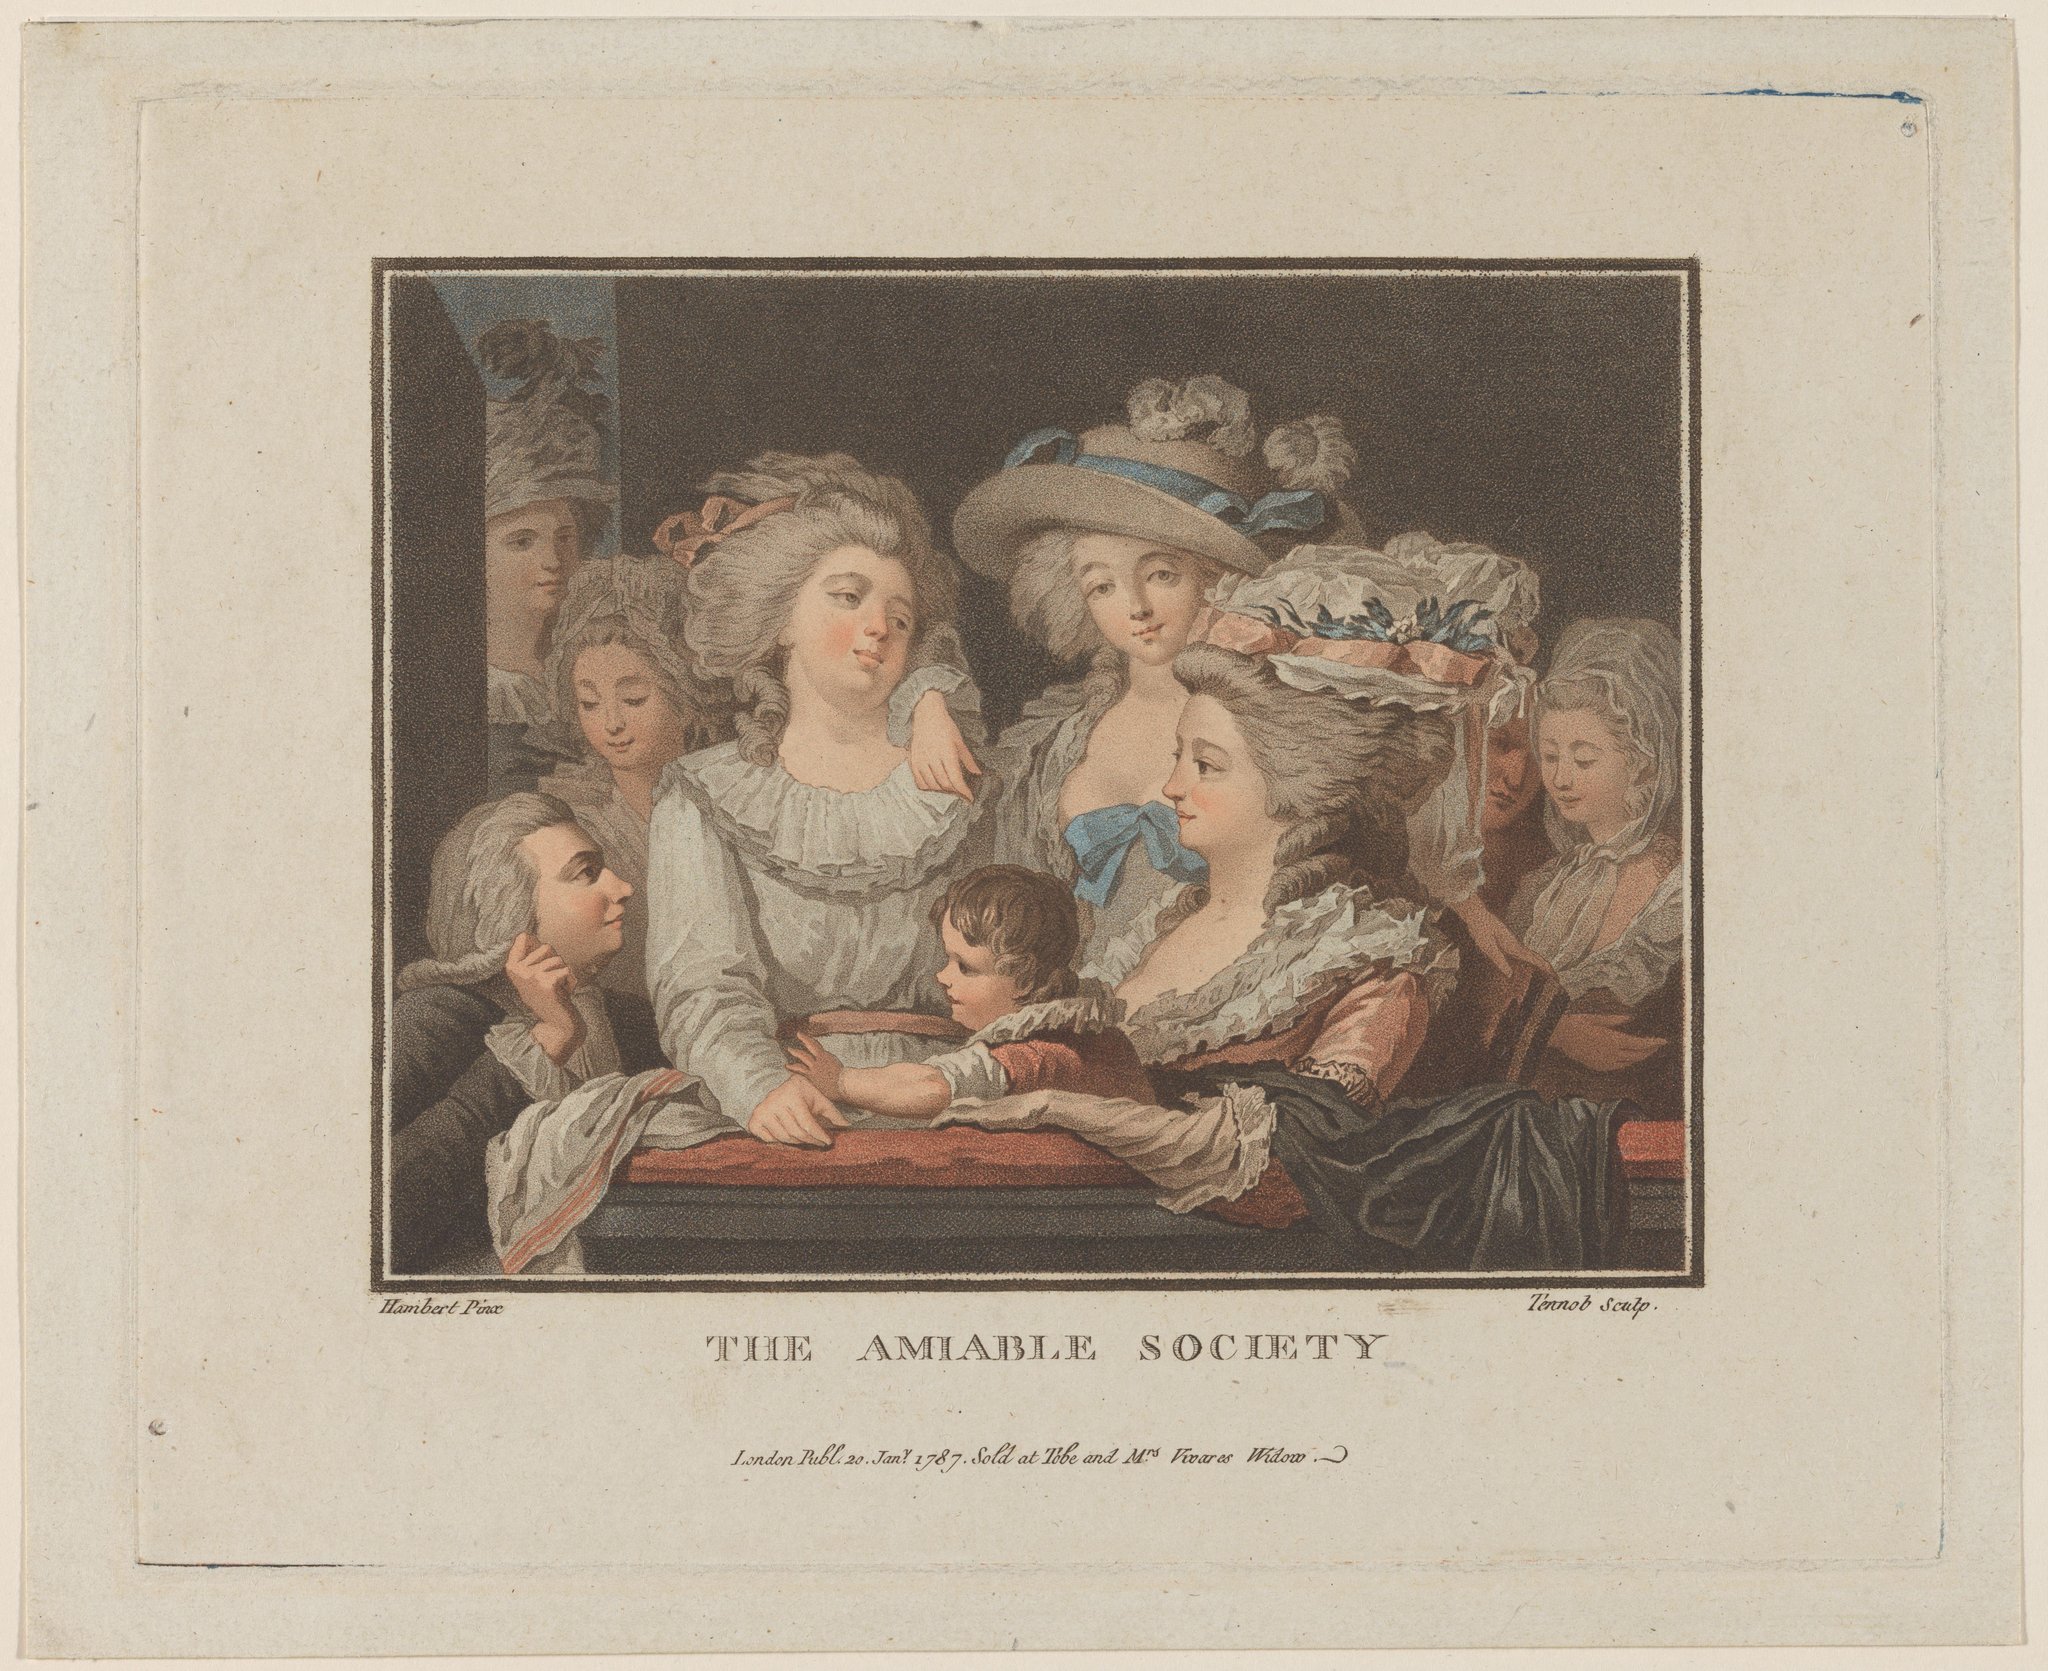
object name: print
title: The amiable society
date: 1787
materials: paper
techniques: engraving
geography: england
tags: boxes, loges ~ theatre, etc., mother and baby or young child, mother-love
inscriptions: collector's mark: Lugt 2228, collector's mark: Lugt 2760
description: Centrale groep van drie vrouwen om een kind, omringd door andere vrouwen en een jongeman. Het gezelschap bestaande uit leden van de familie Polignac is afgebeeld in de loge van een theater.